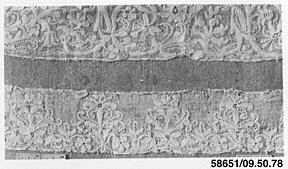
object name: strip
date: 1701-1800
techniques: embroidery